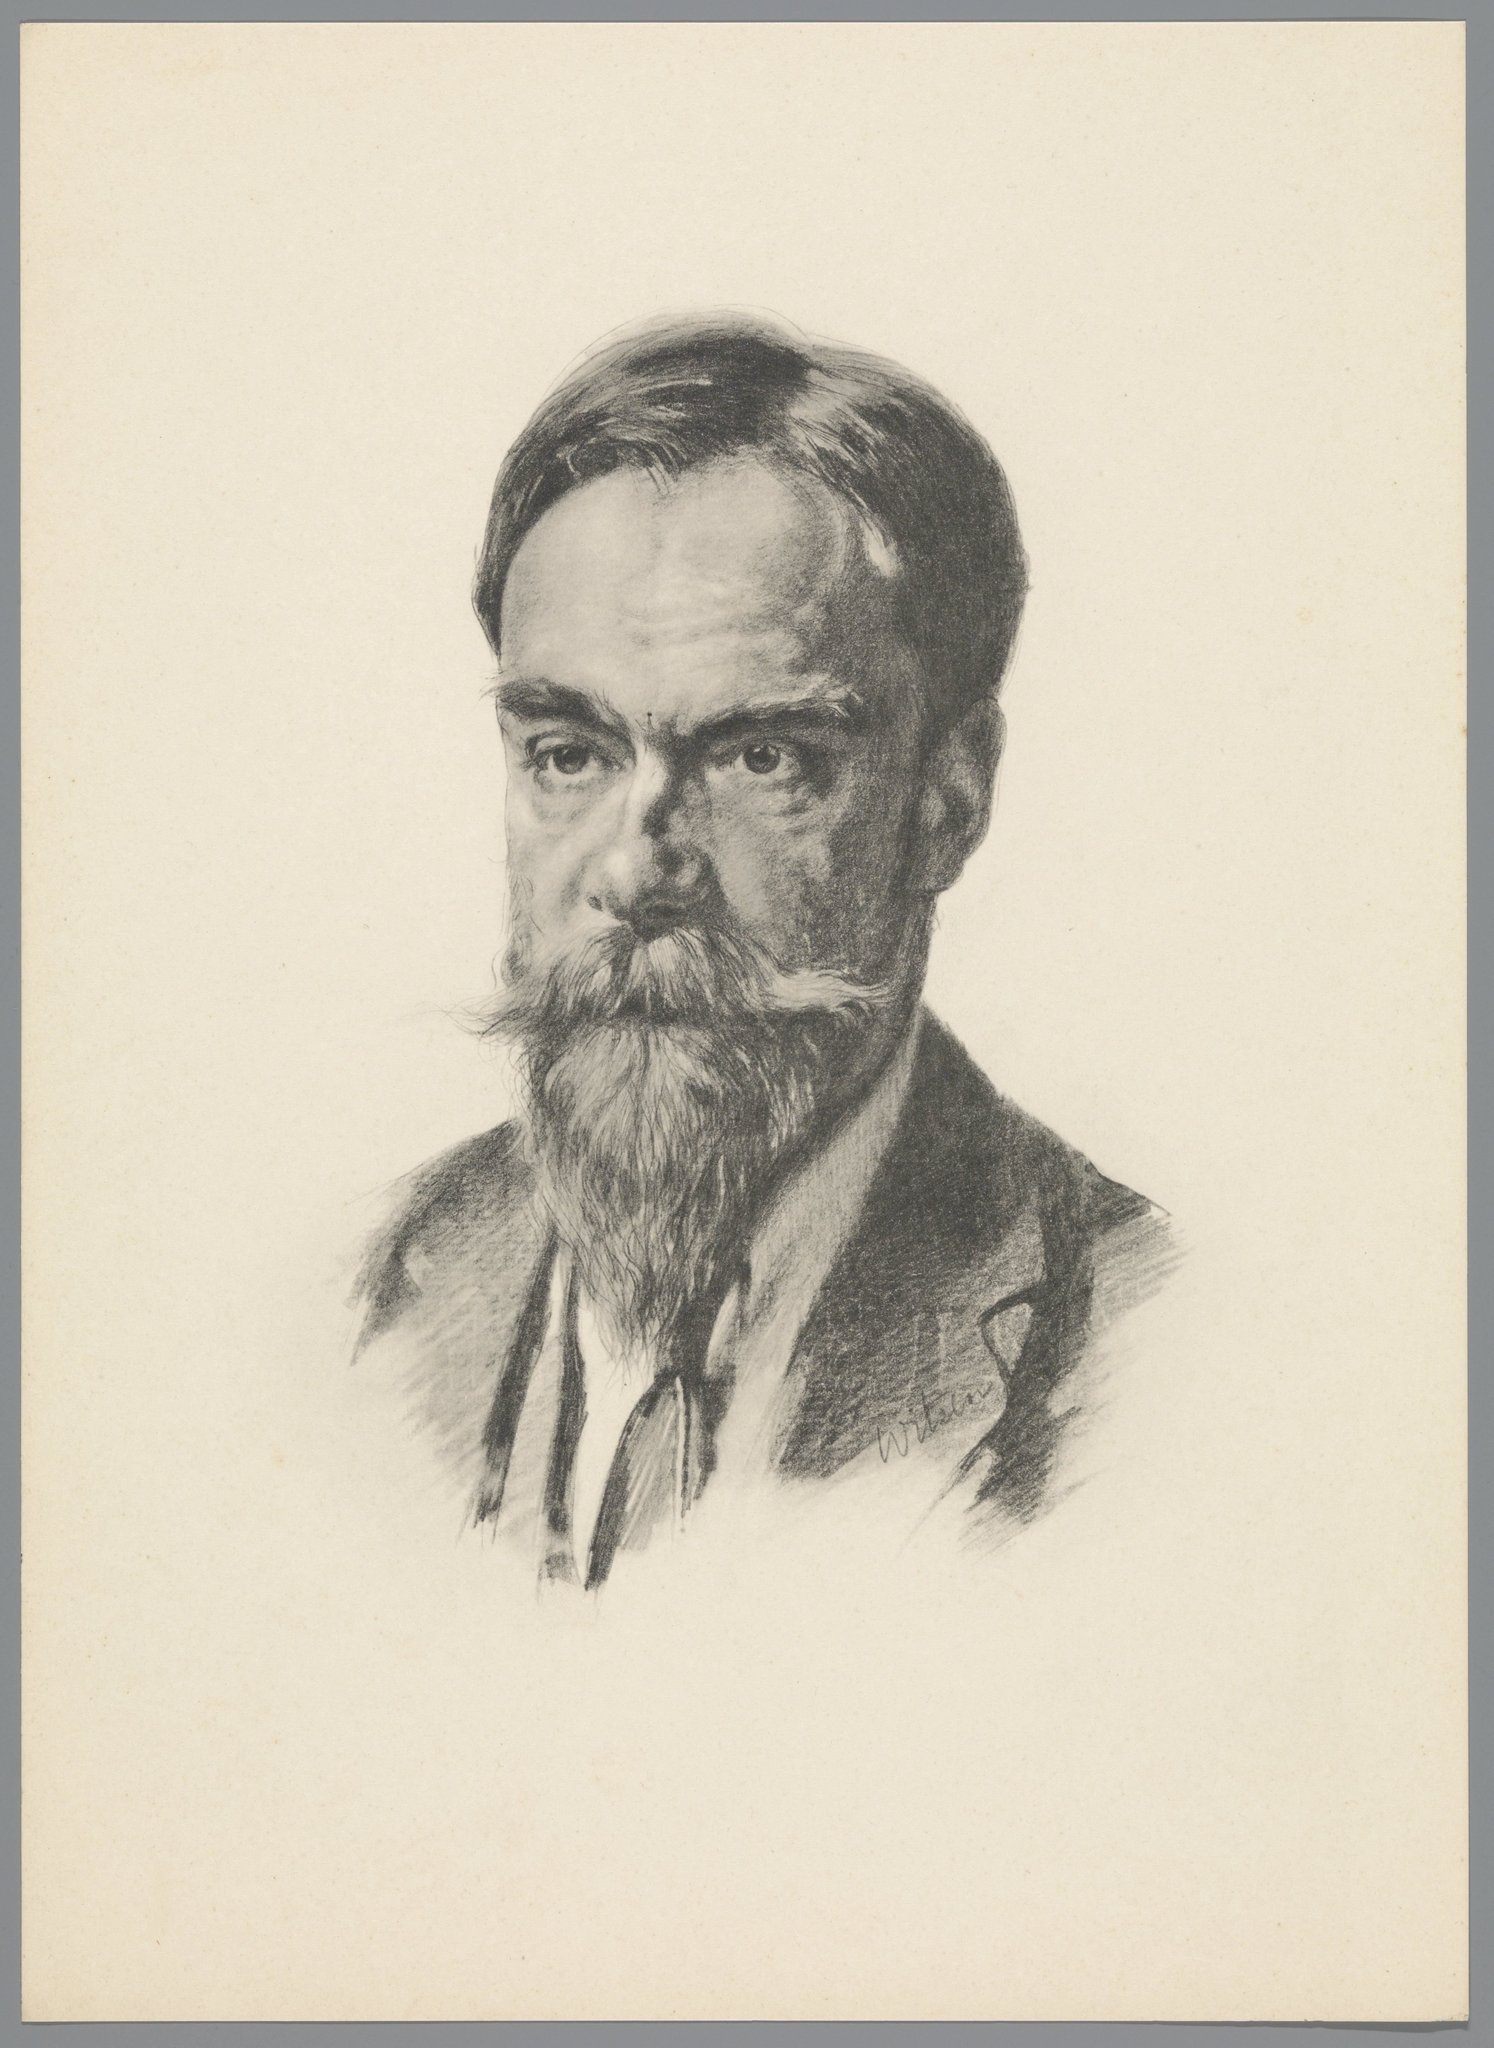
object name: print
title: Reproductie naar krijttekening met portret van Frans Coenen Jr.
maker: Anonymous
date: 1860-1915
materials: paper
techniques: photograph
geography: netherlands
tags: amsterdam, frans coenen (1866-1936)